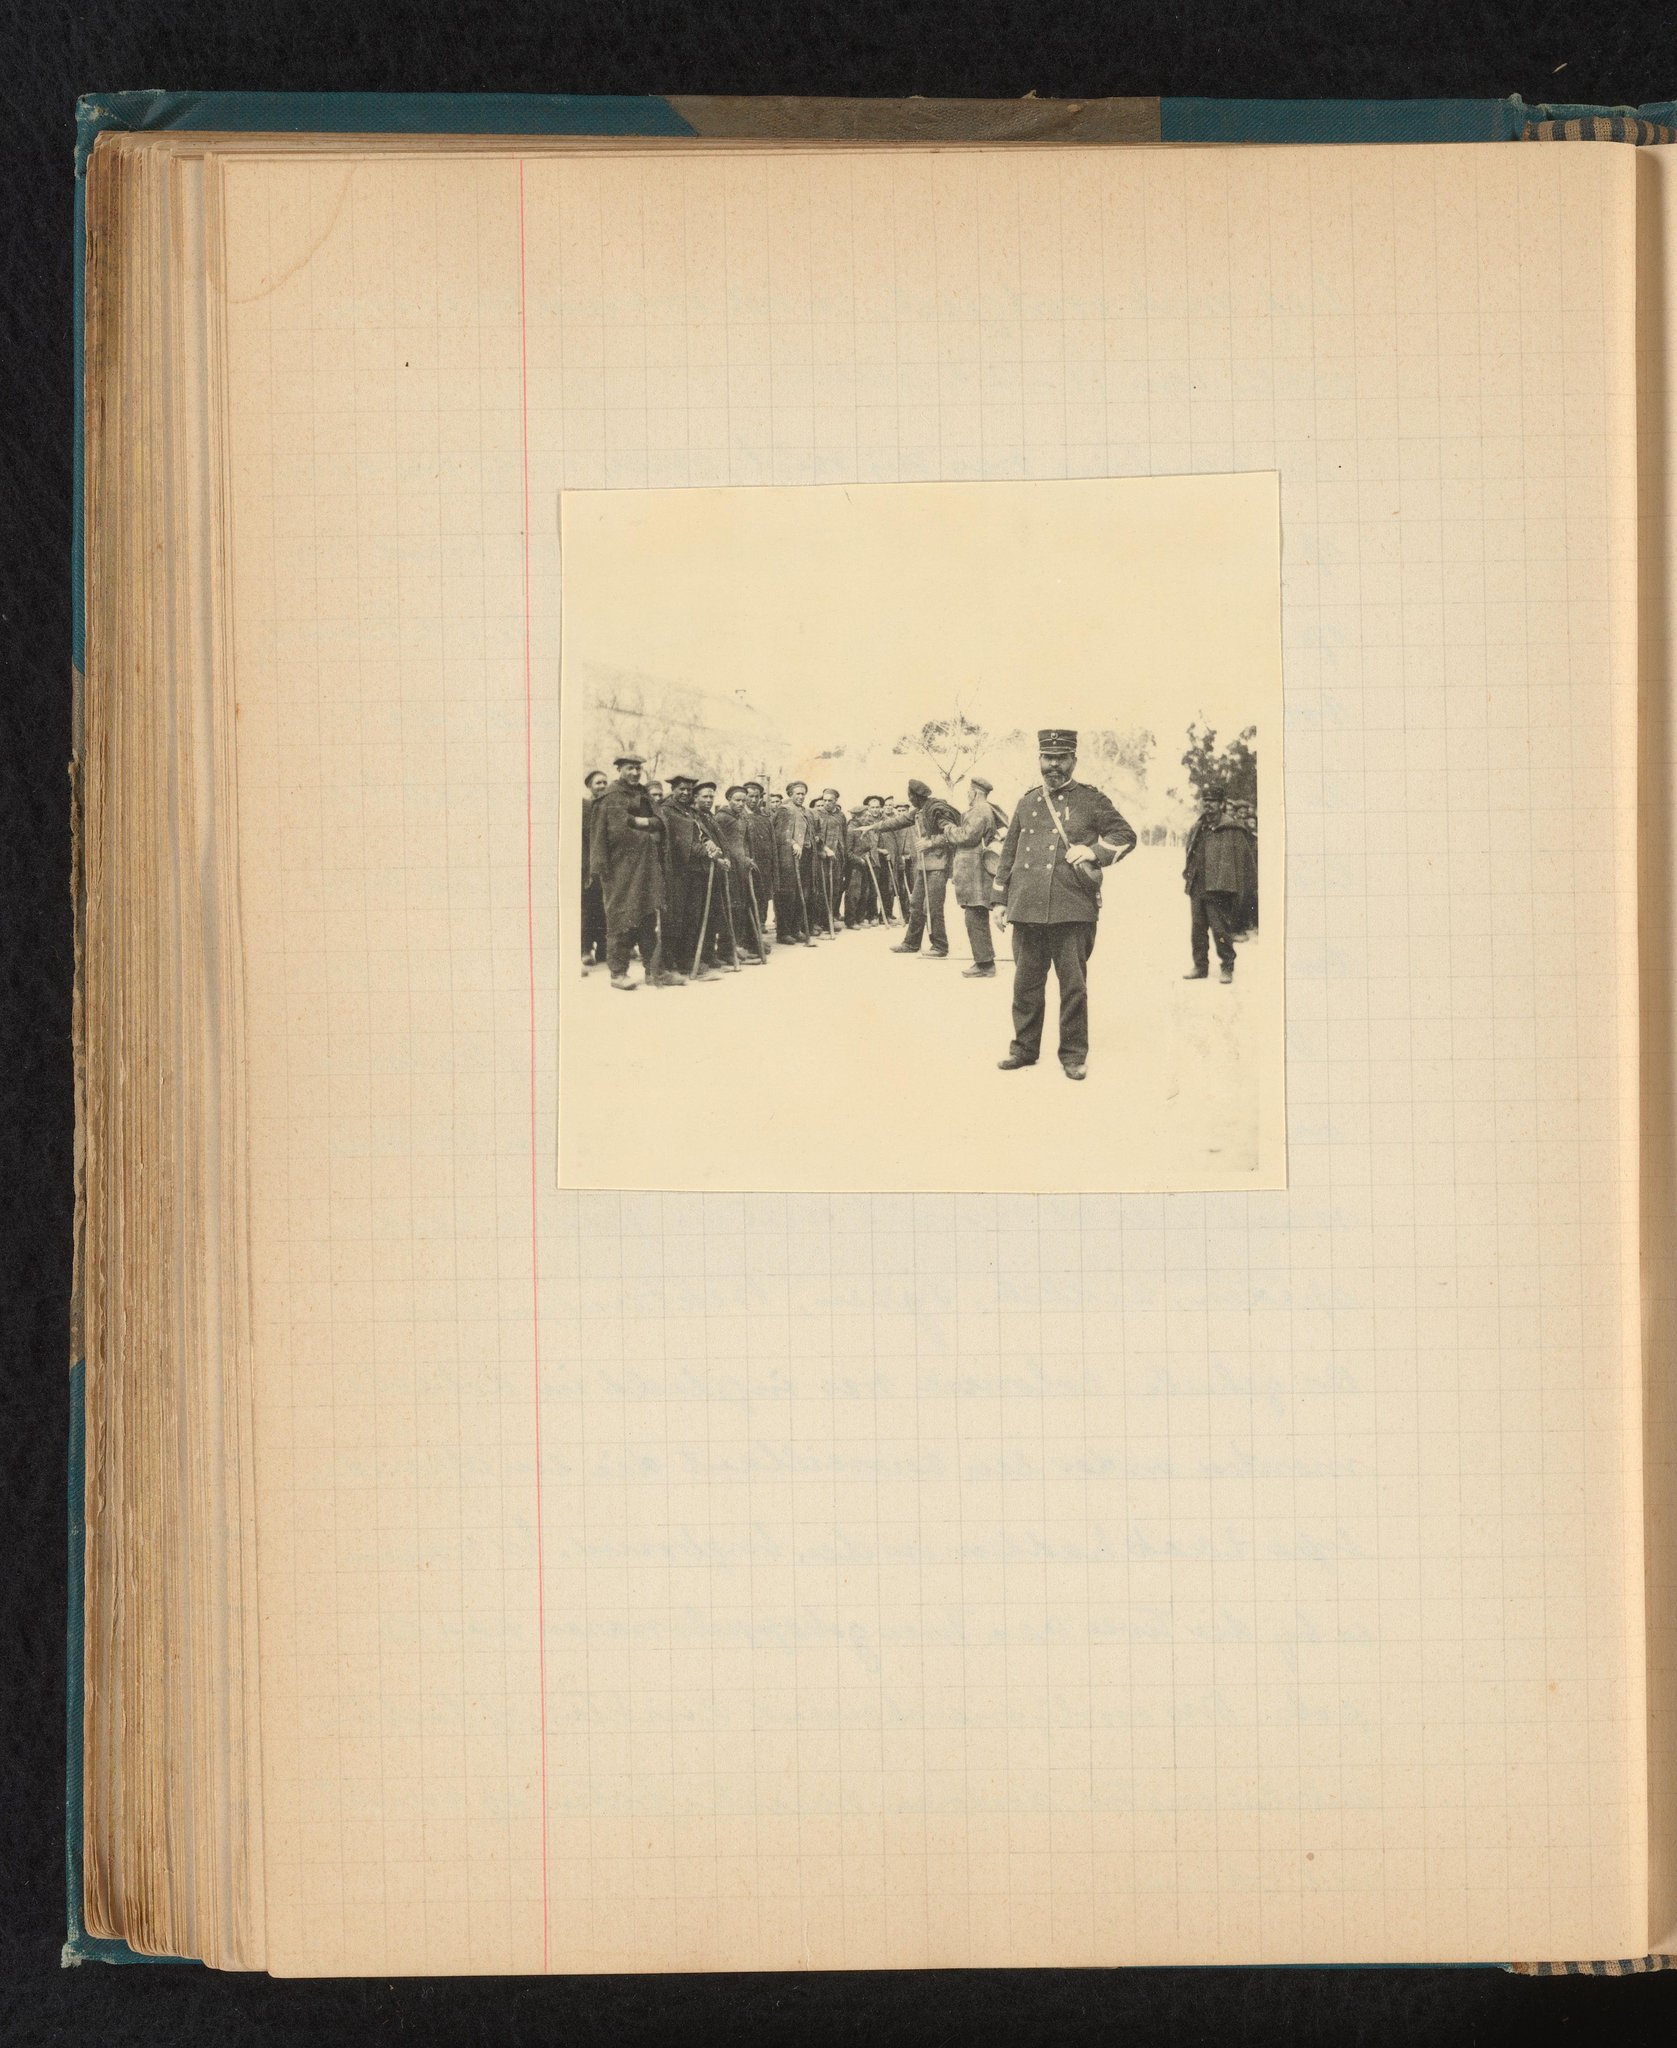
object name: album leaf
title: Bewaker met Arabische gevangenen opgesteld in een rij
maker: théodore van lelyveld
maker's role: painter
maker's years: 1867-1954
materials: paper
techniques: gelatin silver print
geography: chiavari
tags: prison, jail, prison personnel: jailers, warders, guards, historical persons not known by name